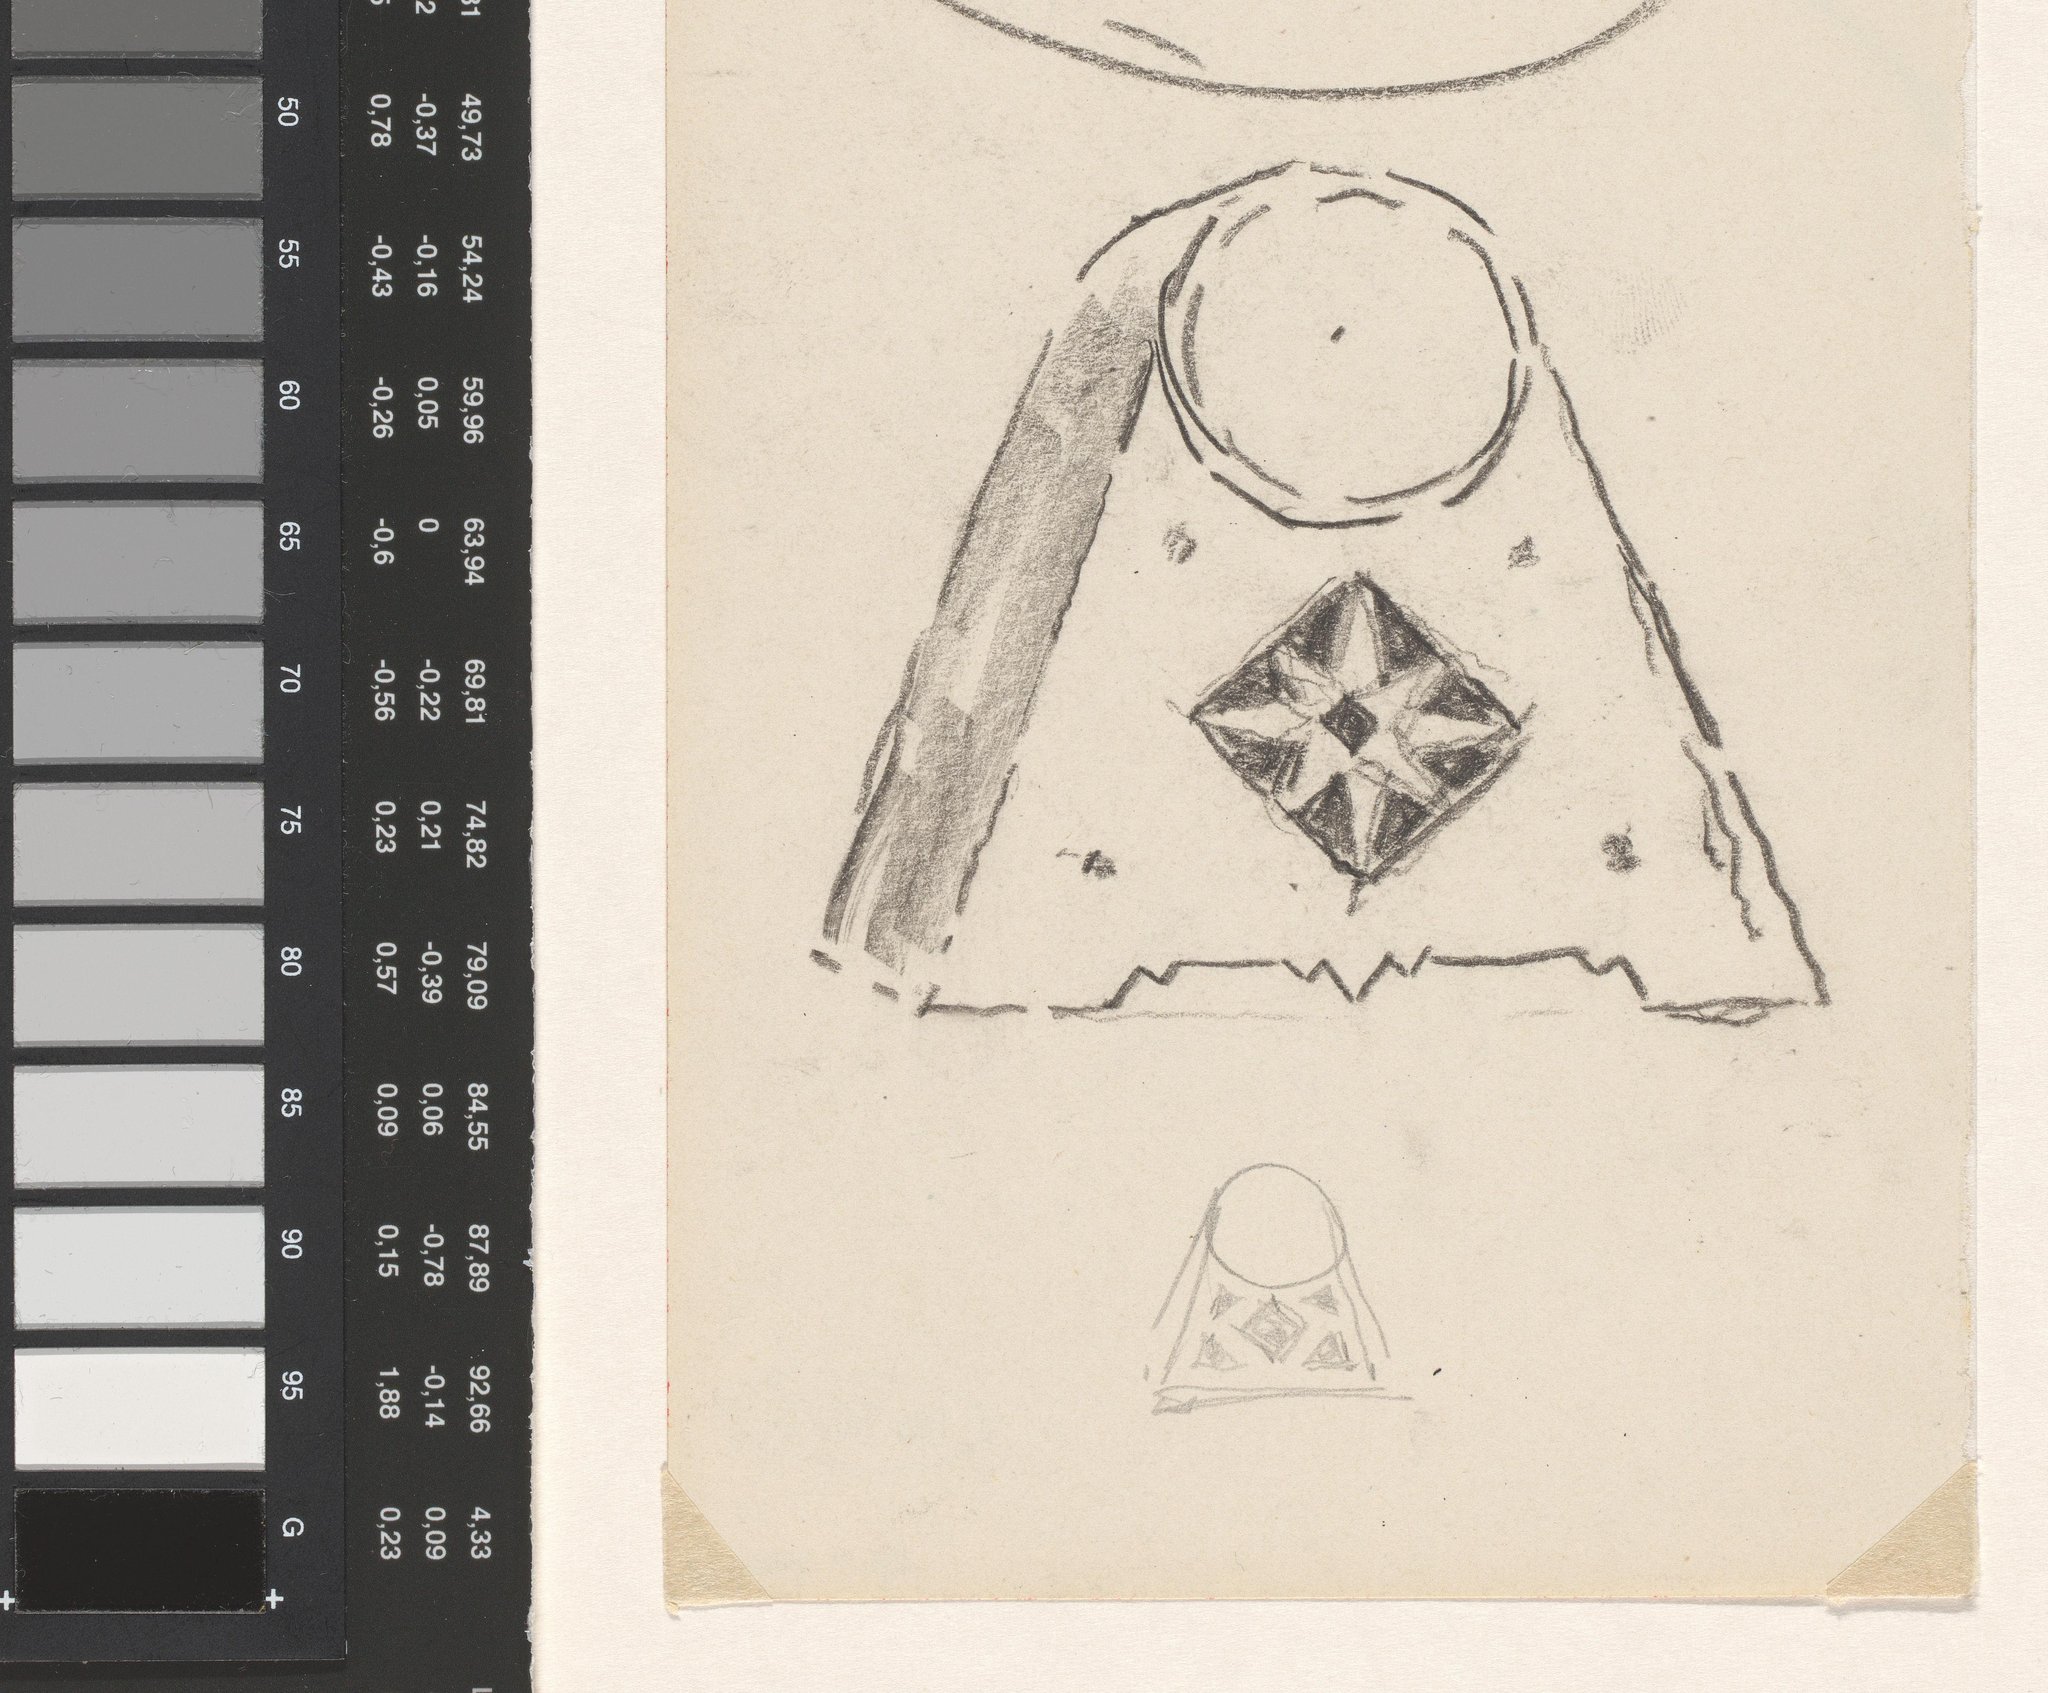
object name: design drawing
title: Ontwerp voor een pendule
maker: gerrit willem dijsselhof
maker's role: designer, draughtsman, print maker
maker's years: 1866-1924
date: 1881-1924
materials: chalk, paper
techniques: drawing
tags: clock